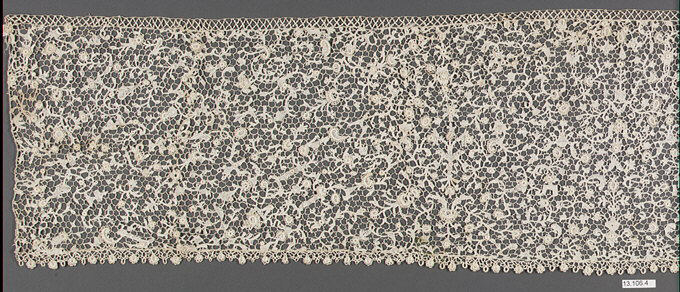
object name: flounce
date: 1651-1700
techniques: lace